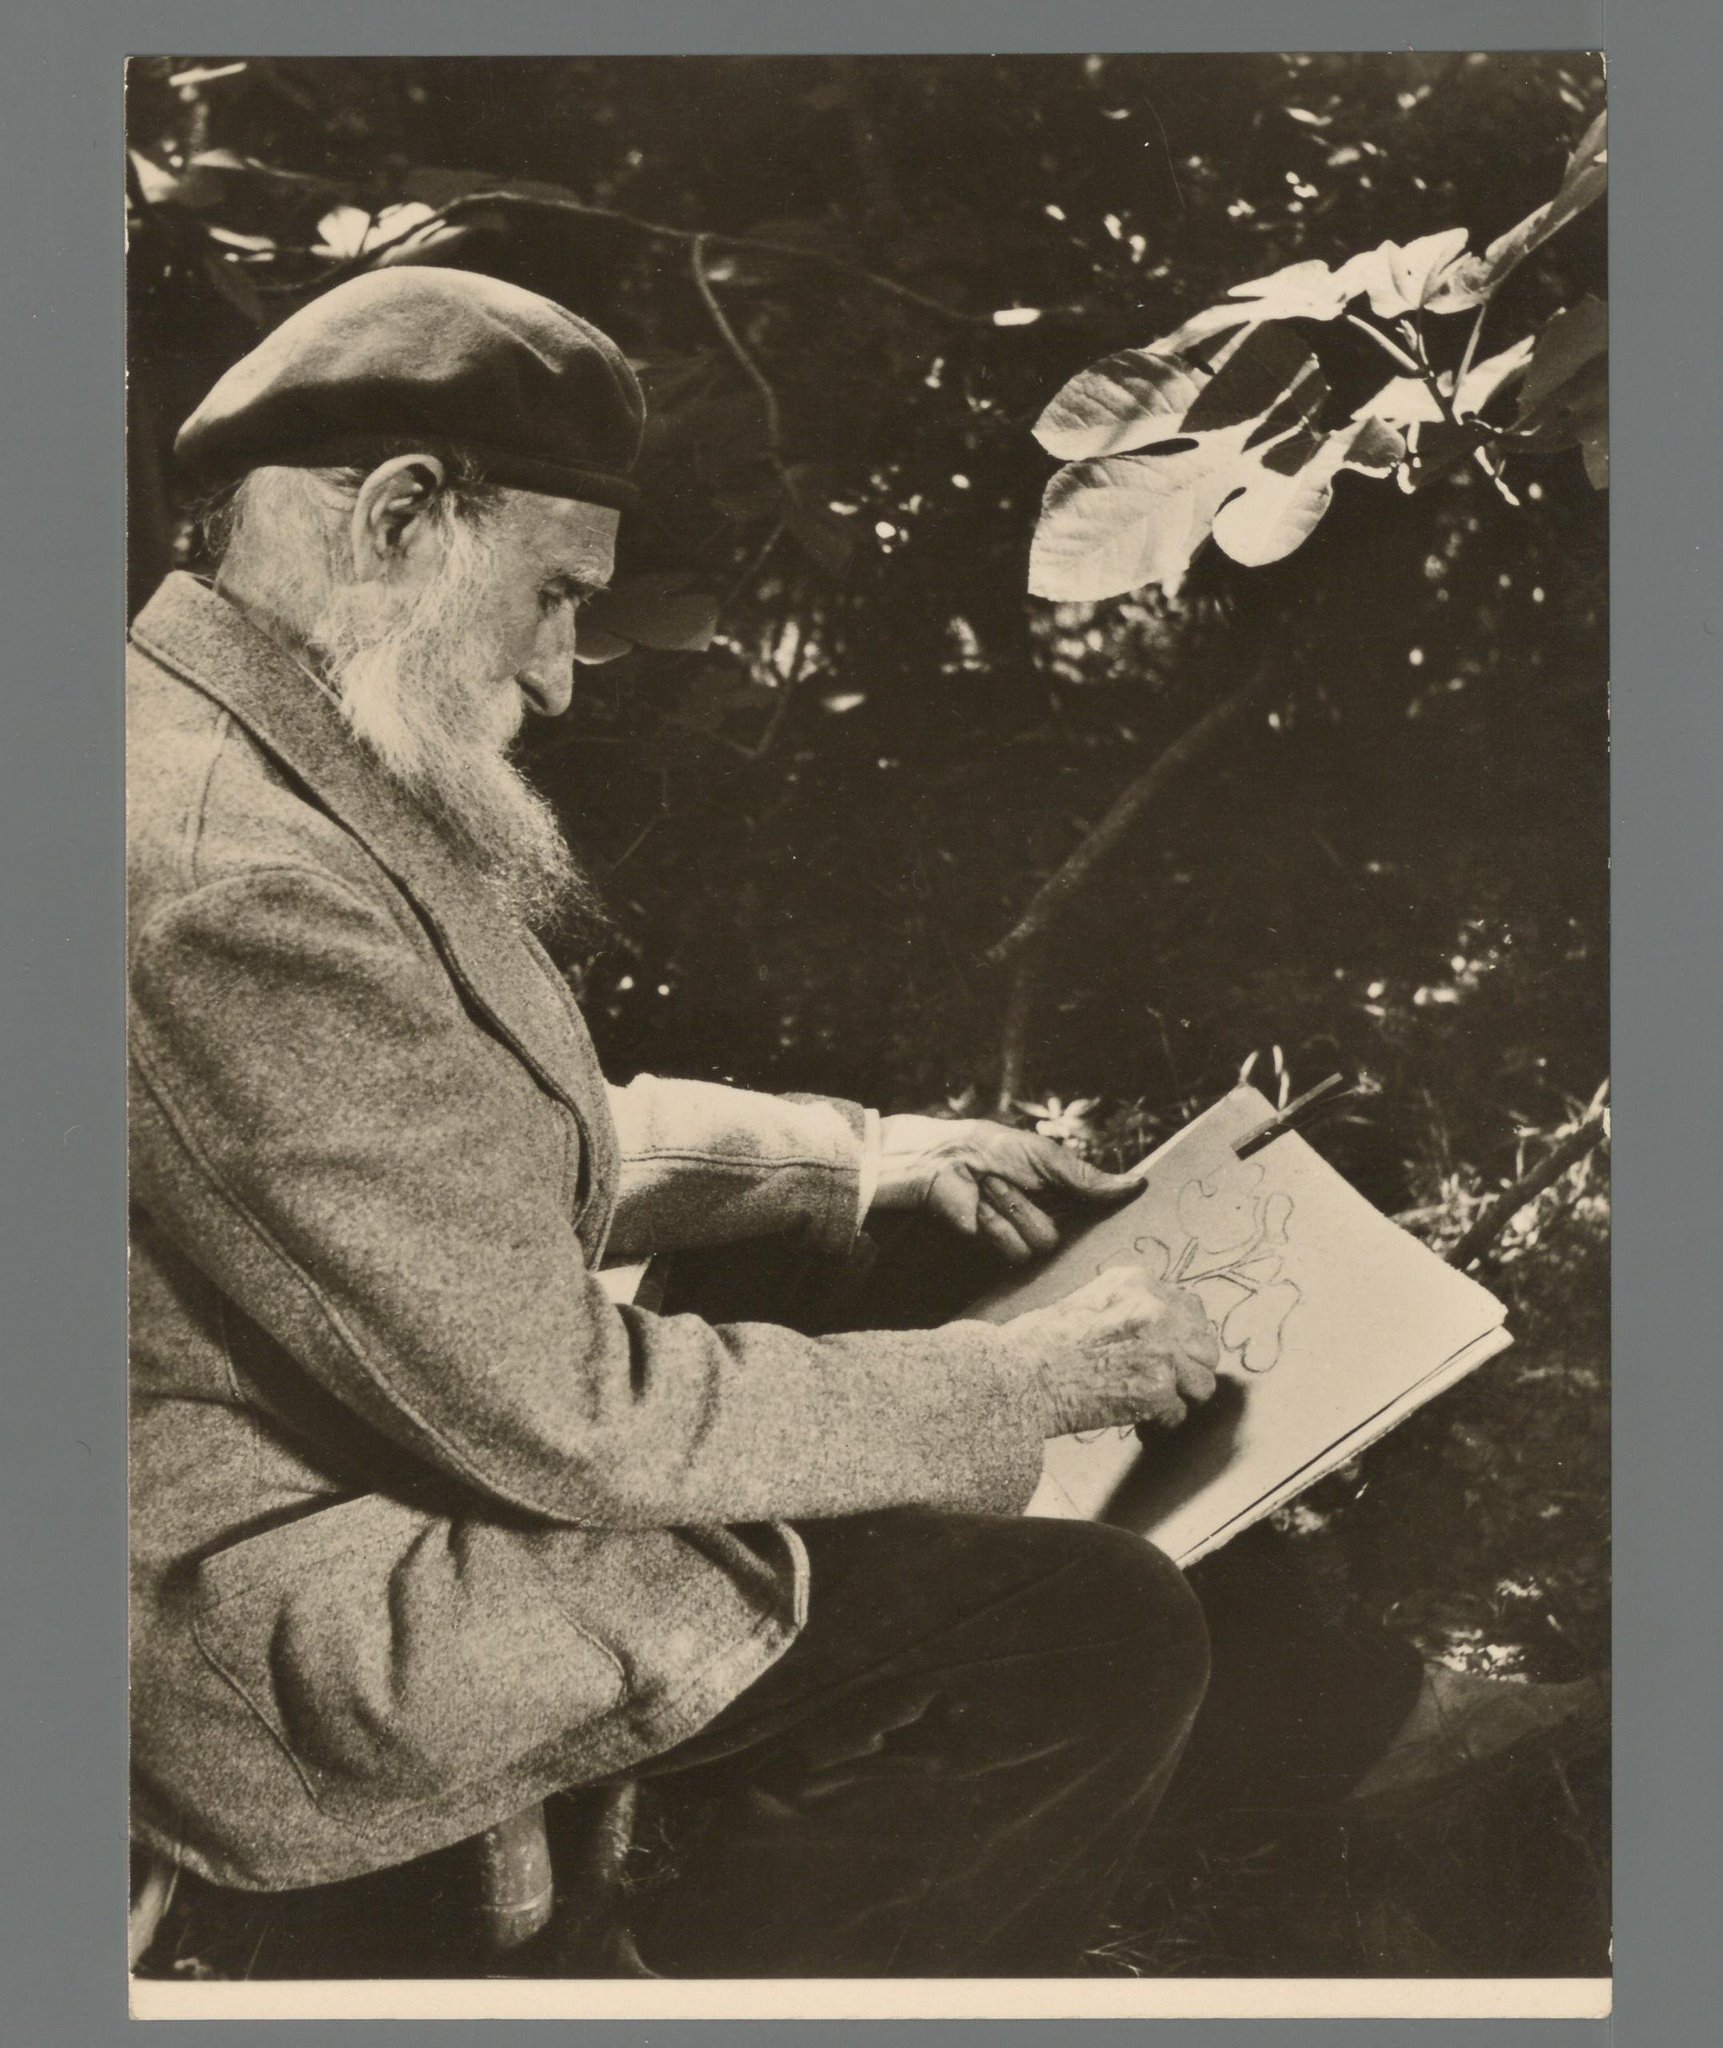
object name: ansichtkaart, prentbriefkaart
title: "Die Meister". Nr. 795: Aristide Maillol (1861-1944), im Garten seines Landhauses in Banyuls, 1943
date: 1943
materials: photographic support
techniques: photography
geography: cologne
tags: painter, print maker, draughtsman, sculptor, aristide maillol, garden, portrait, self-portrait of artist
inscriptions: date